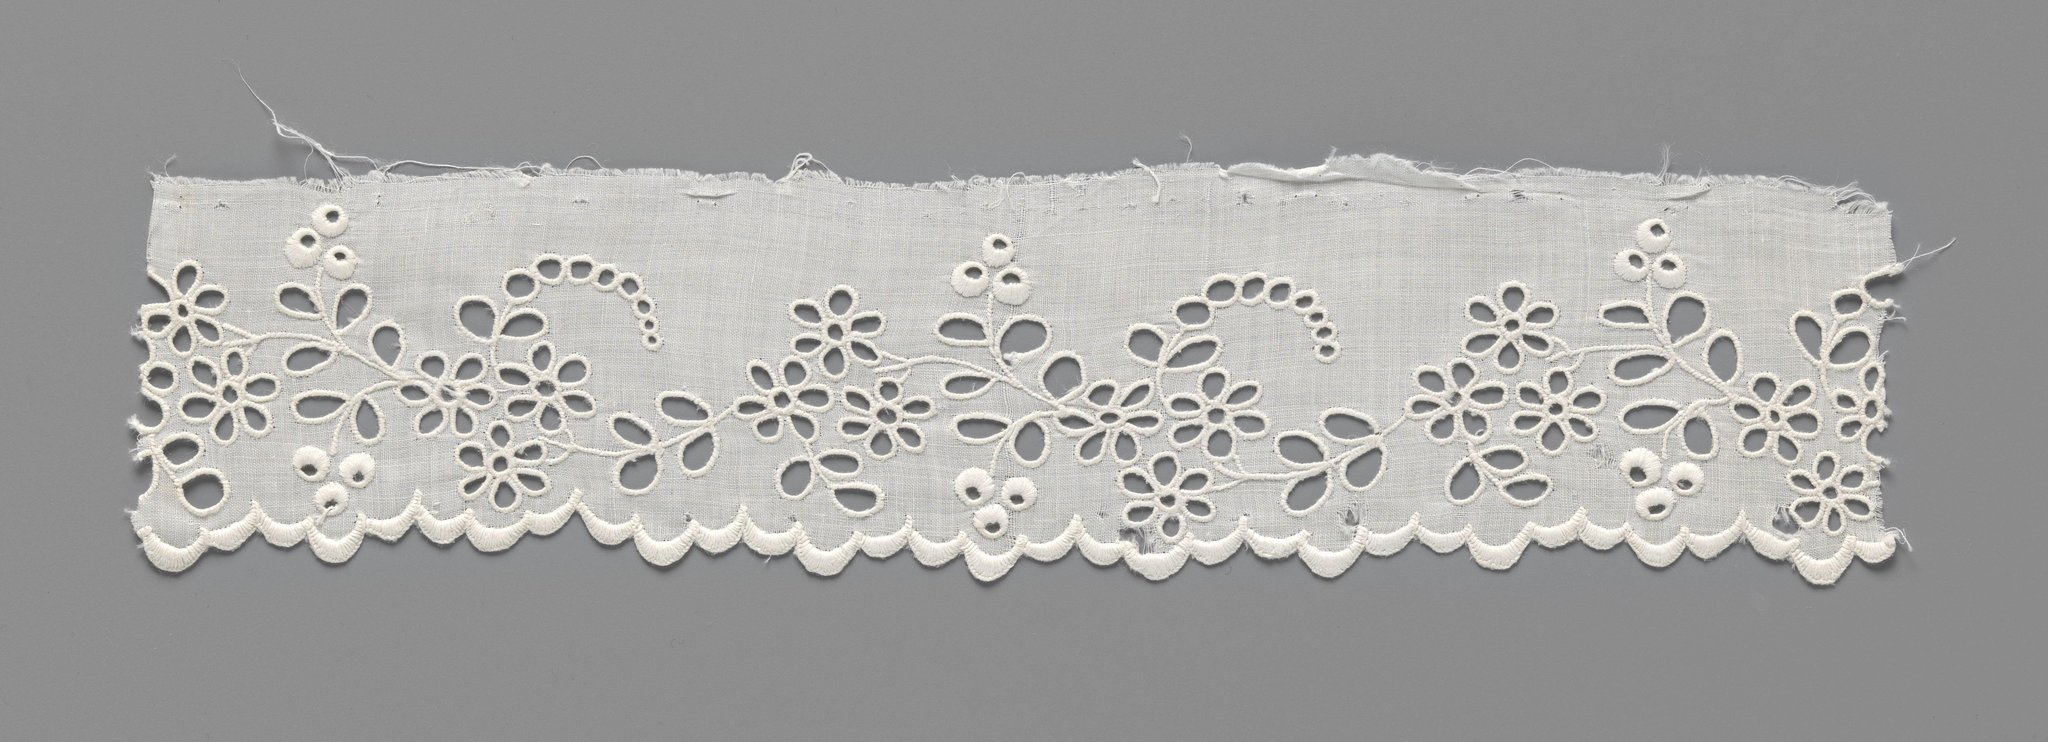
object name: fragment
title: Strook katoen met kantborduurwerk met opengewerkte bloemen en bessen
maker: c.i. bosch reitz-teding van berkhout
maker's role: kantwerkster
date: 1860-1880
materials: cotton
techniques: weave, embroidery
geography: amsterdam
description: Strook naturelkleurig katoen met kantborduurwerk: Engels borduurwerk. De strook heeft een schulpenrand en een zich herhalend en doorlopend patroon met een golvende rank met opengewerkte bloemen, bladeren en bessen.